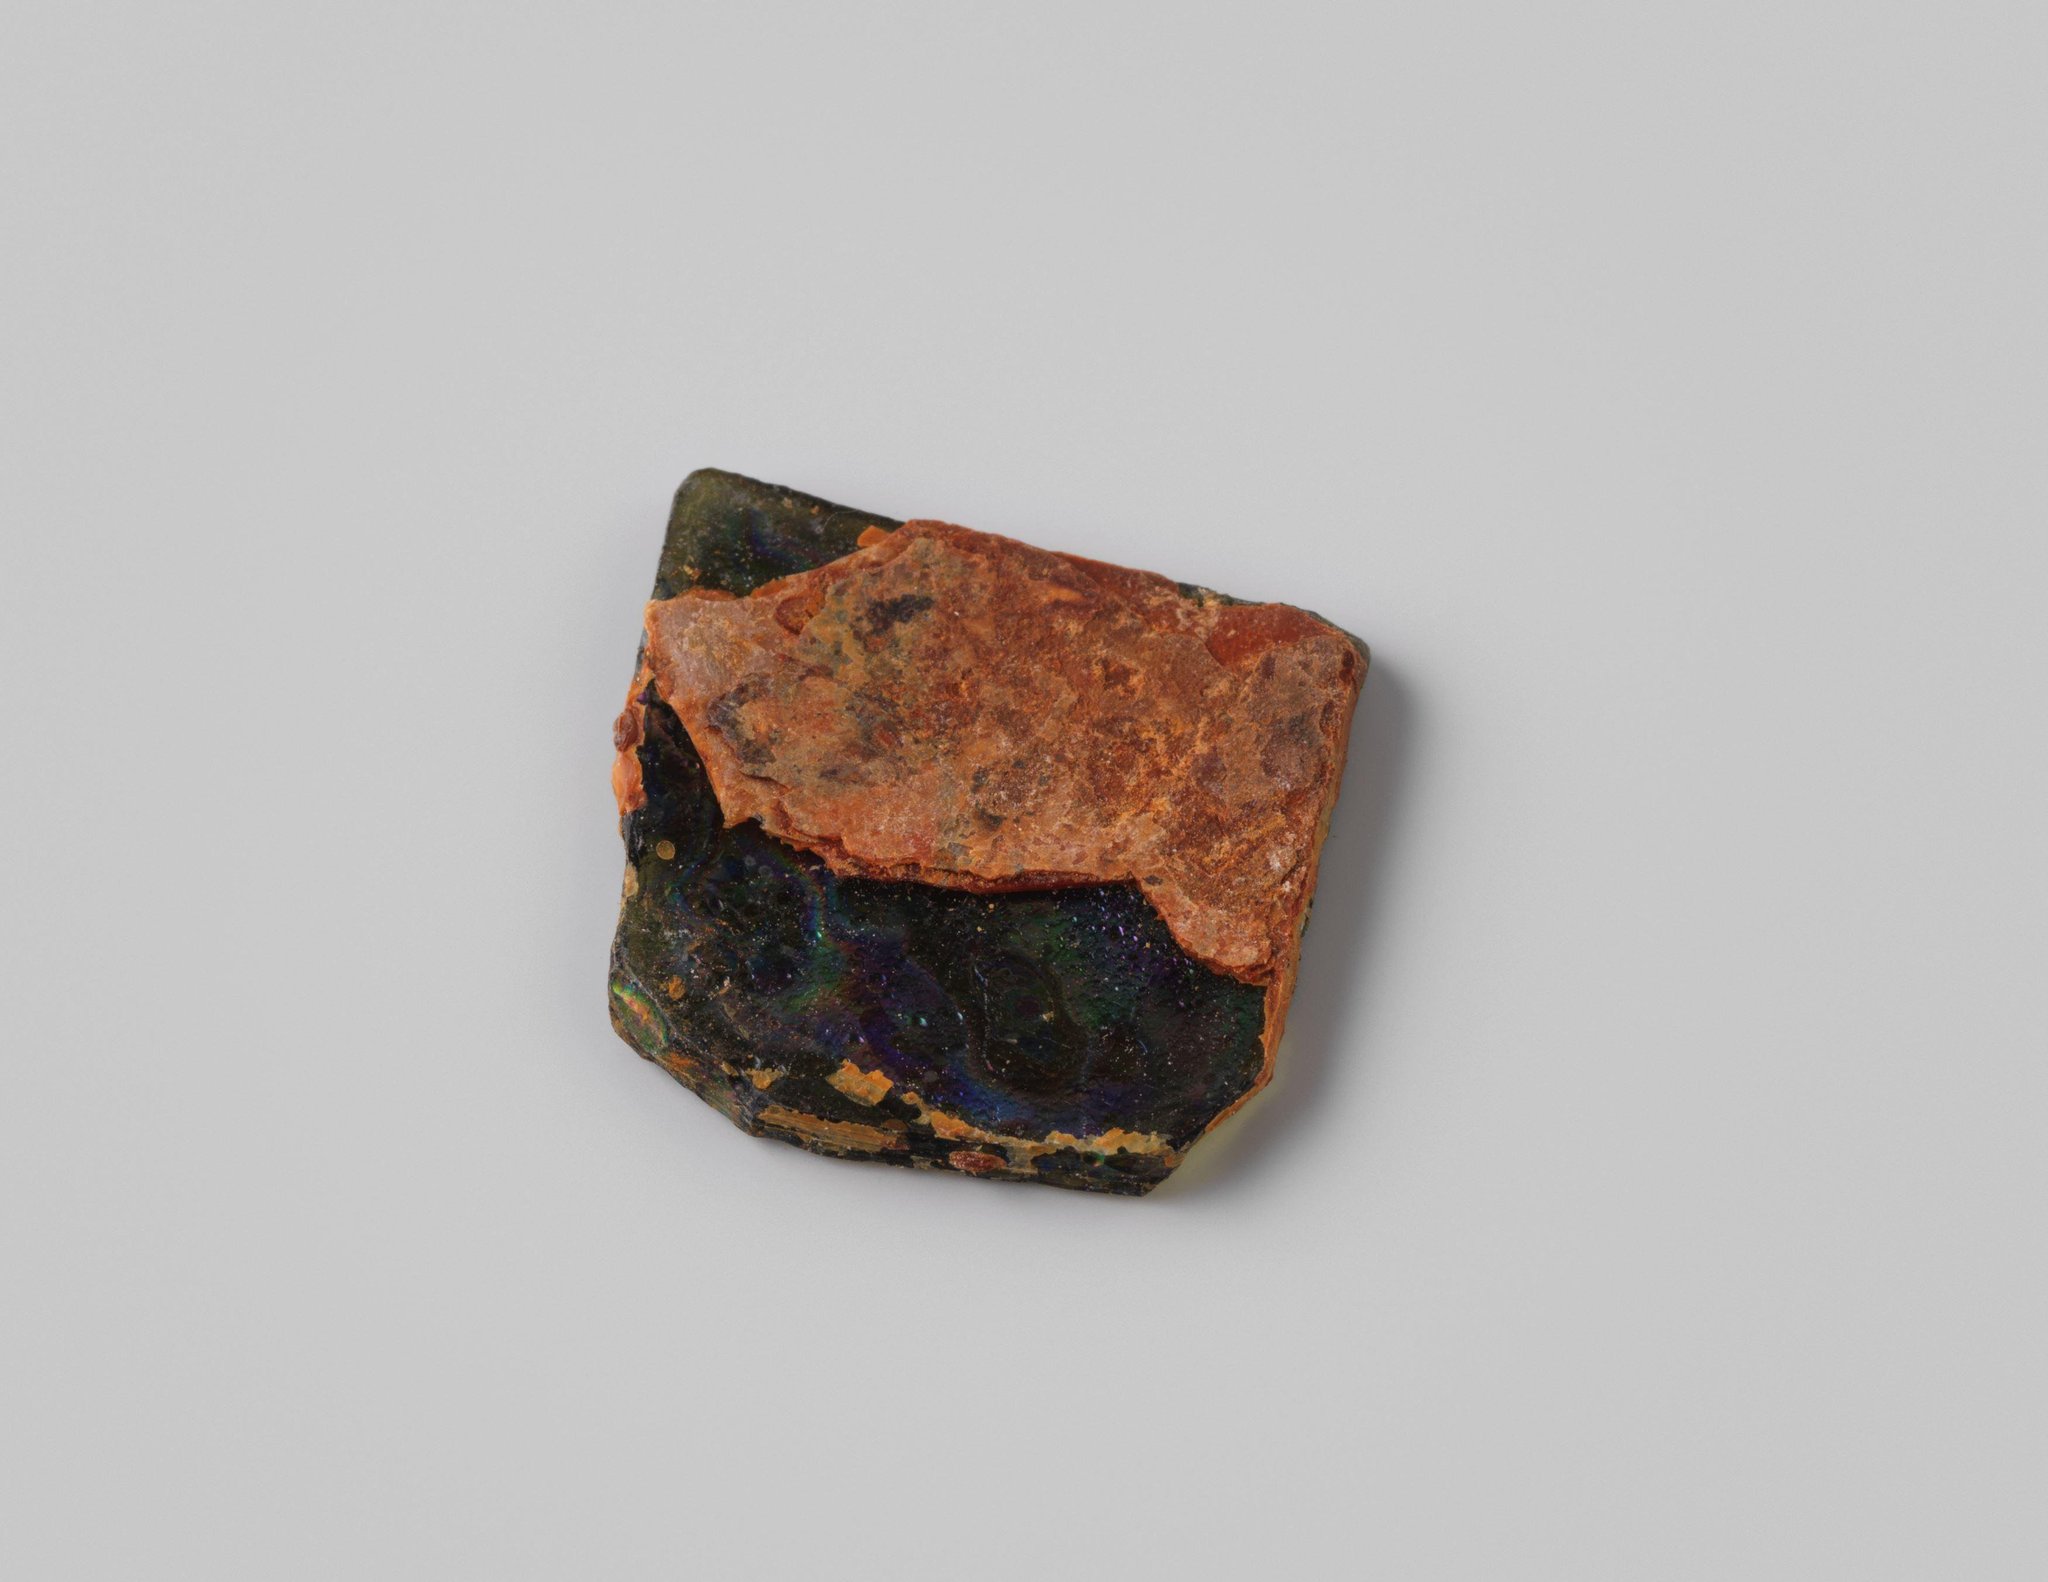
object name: sherd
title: Scherf van een wijnfles uit het wrak van de Oost-Indiëvaarder Hollandia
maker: Anonymous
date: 1700-1743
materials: glass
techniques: green glass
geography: netherlands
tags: verenigde oostindische compagnie, hollandia (schip), annet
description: Typologically not identifiable, flat fragment, fragment.